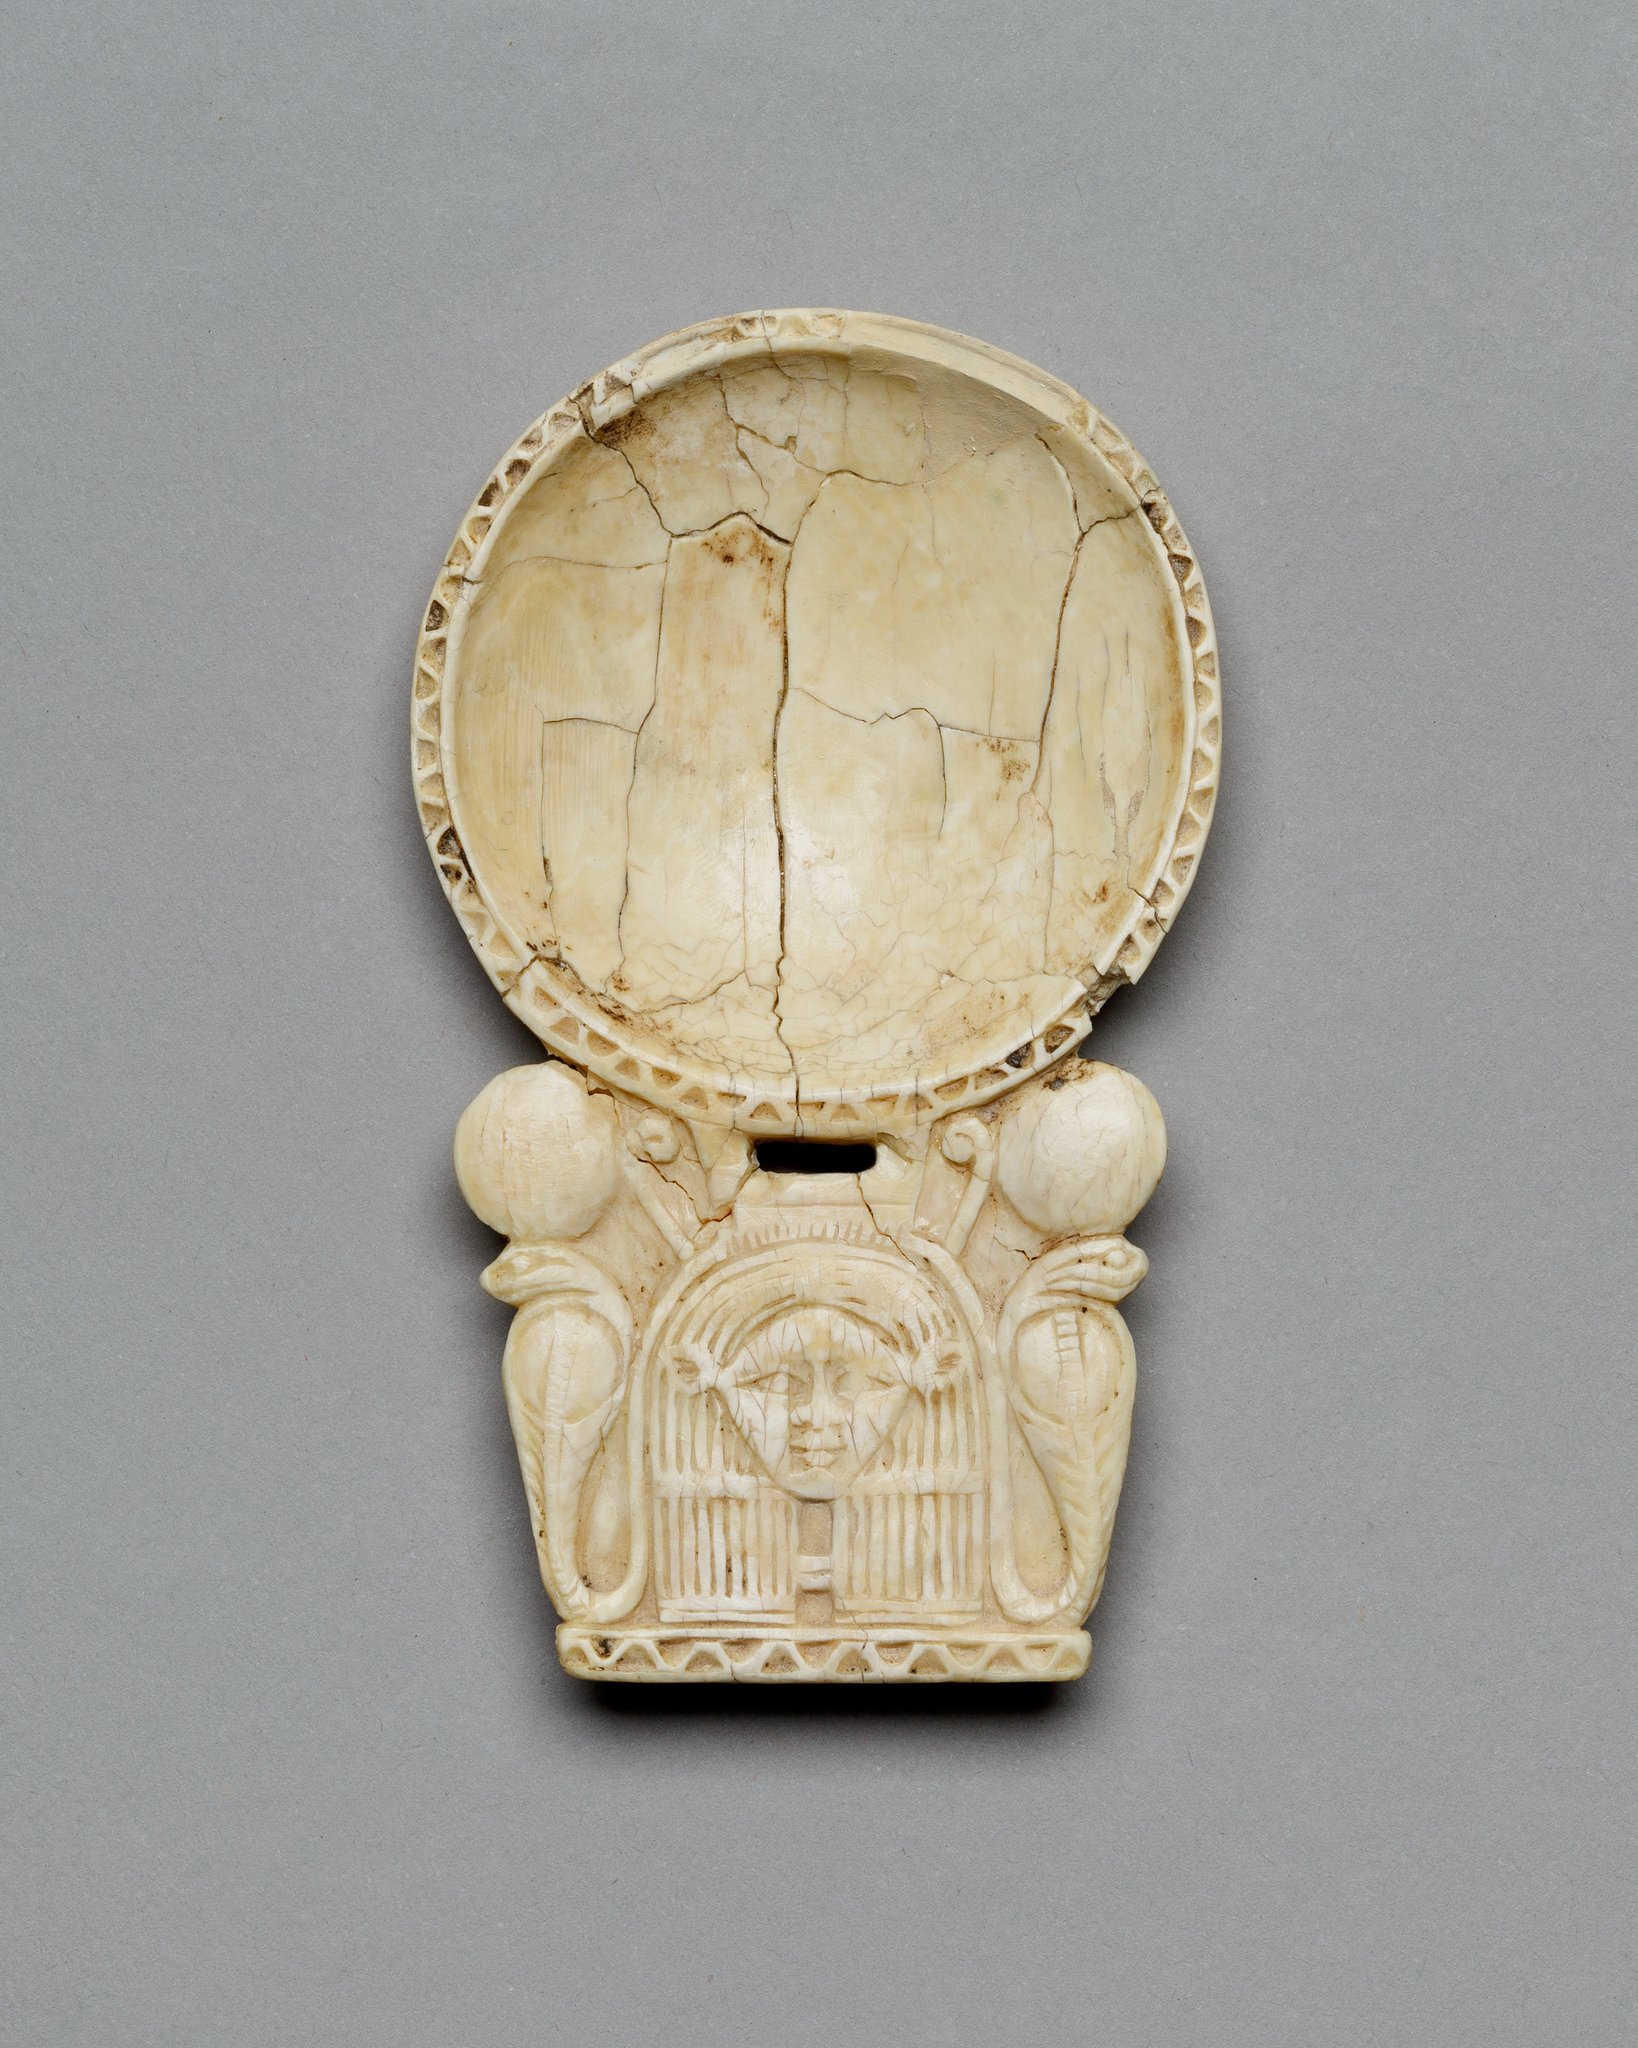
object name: cosmetic spoon, hathor head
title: Cosmetic Spoon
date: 1295-1070 BCE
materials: ivory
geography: egypt